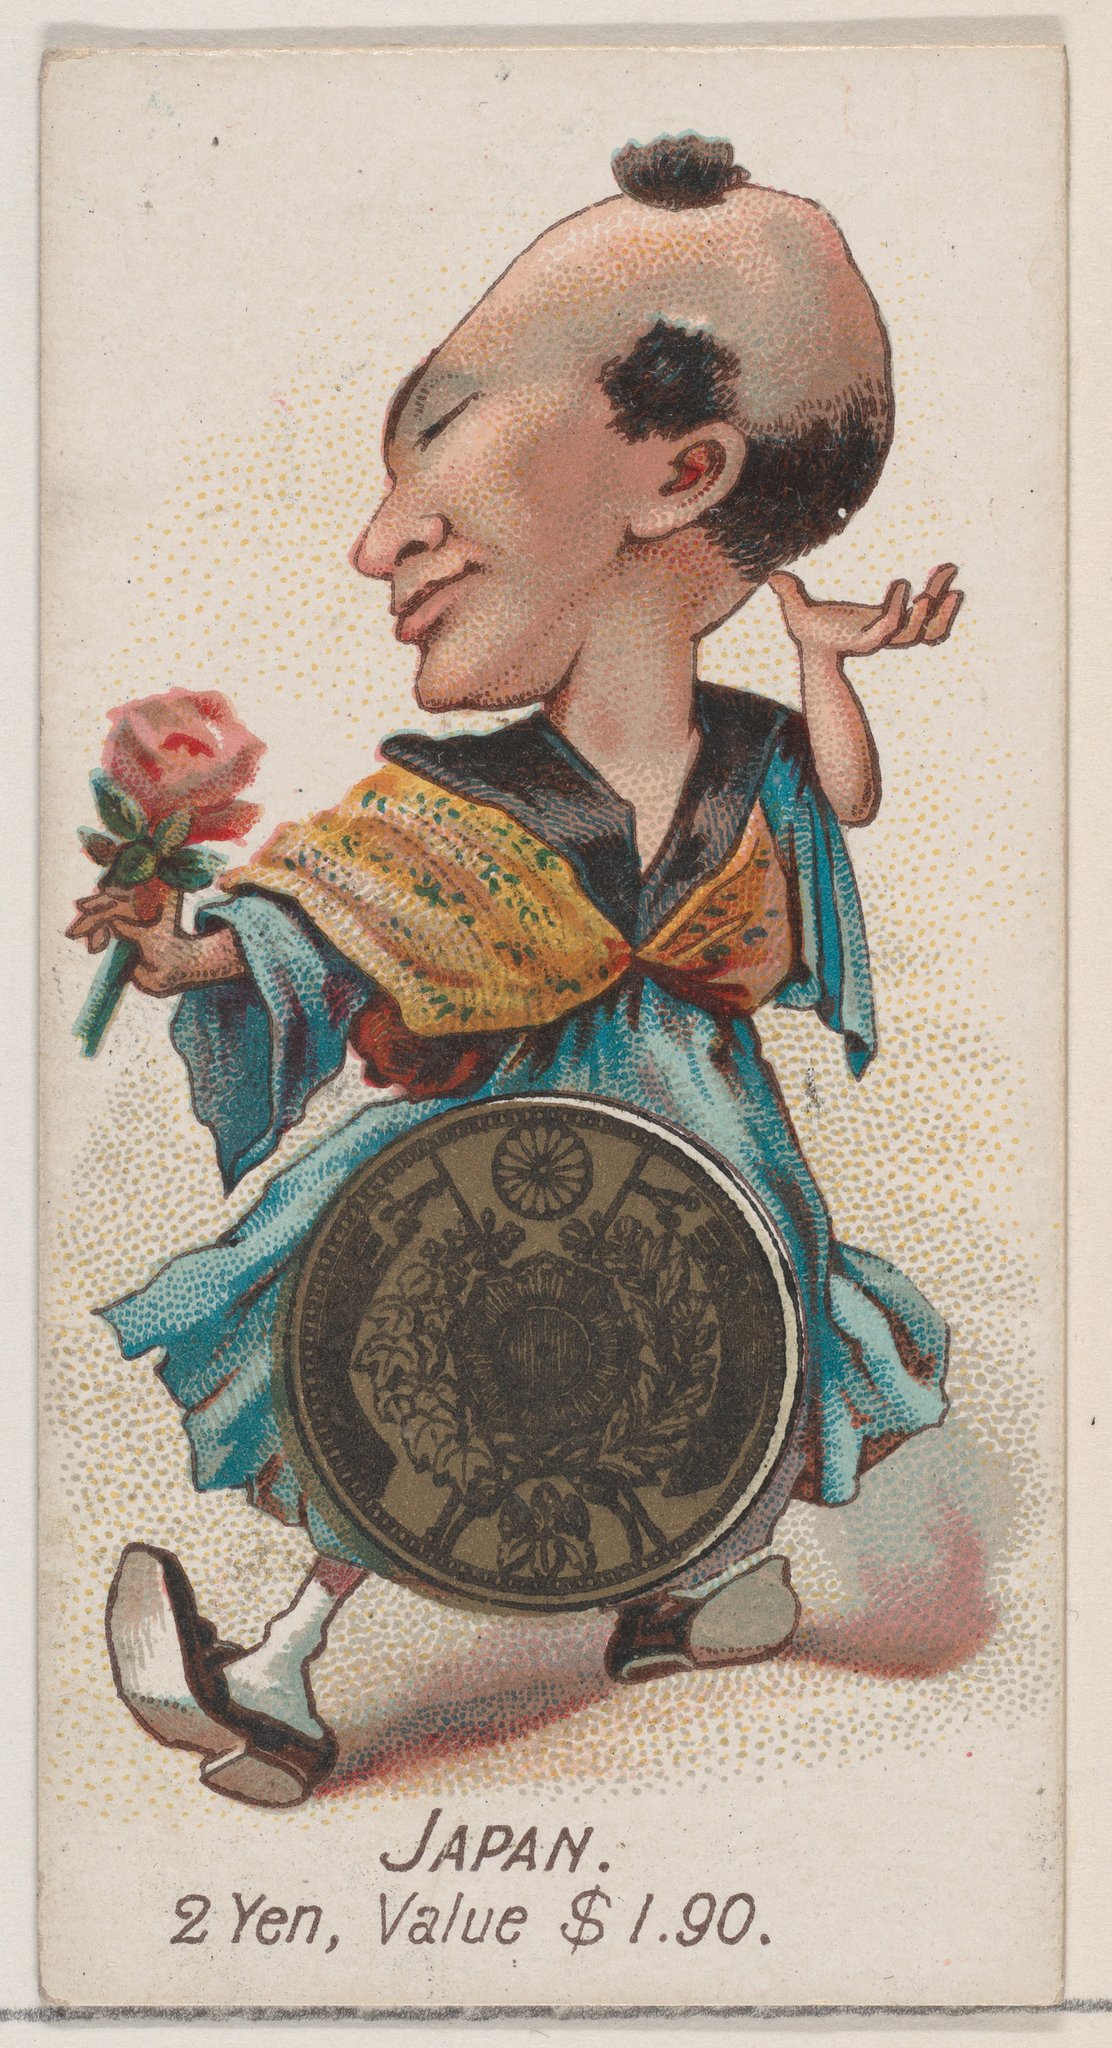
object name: print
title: Caricatured Japanese figure, 2 Yen, from the series Coins of All Nations (N72, variation 1) for Duke brand cigarettes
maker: w. duke, sons & co.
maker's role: publisher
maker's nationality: american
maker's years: 1870-1920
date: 1889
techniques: color lithograph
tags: coins